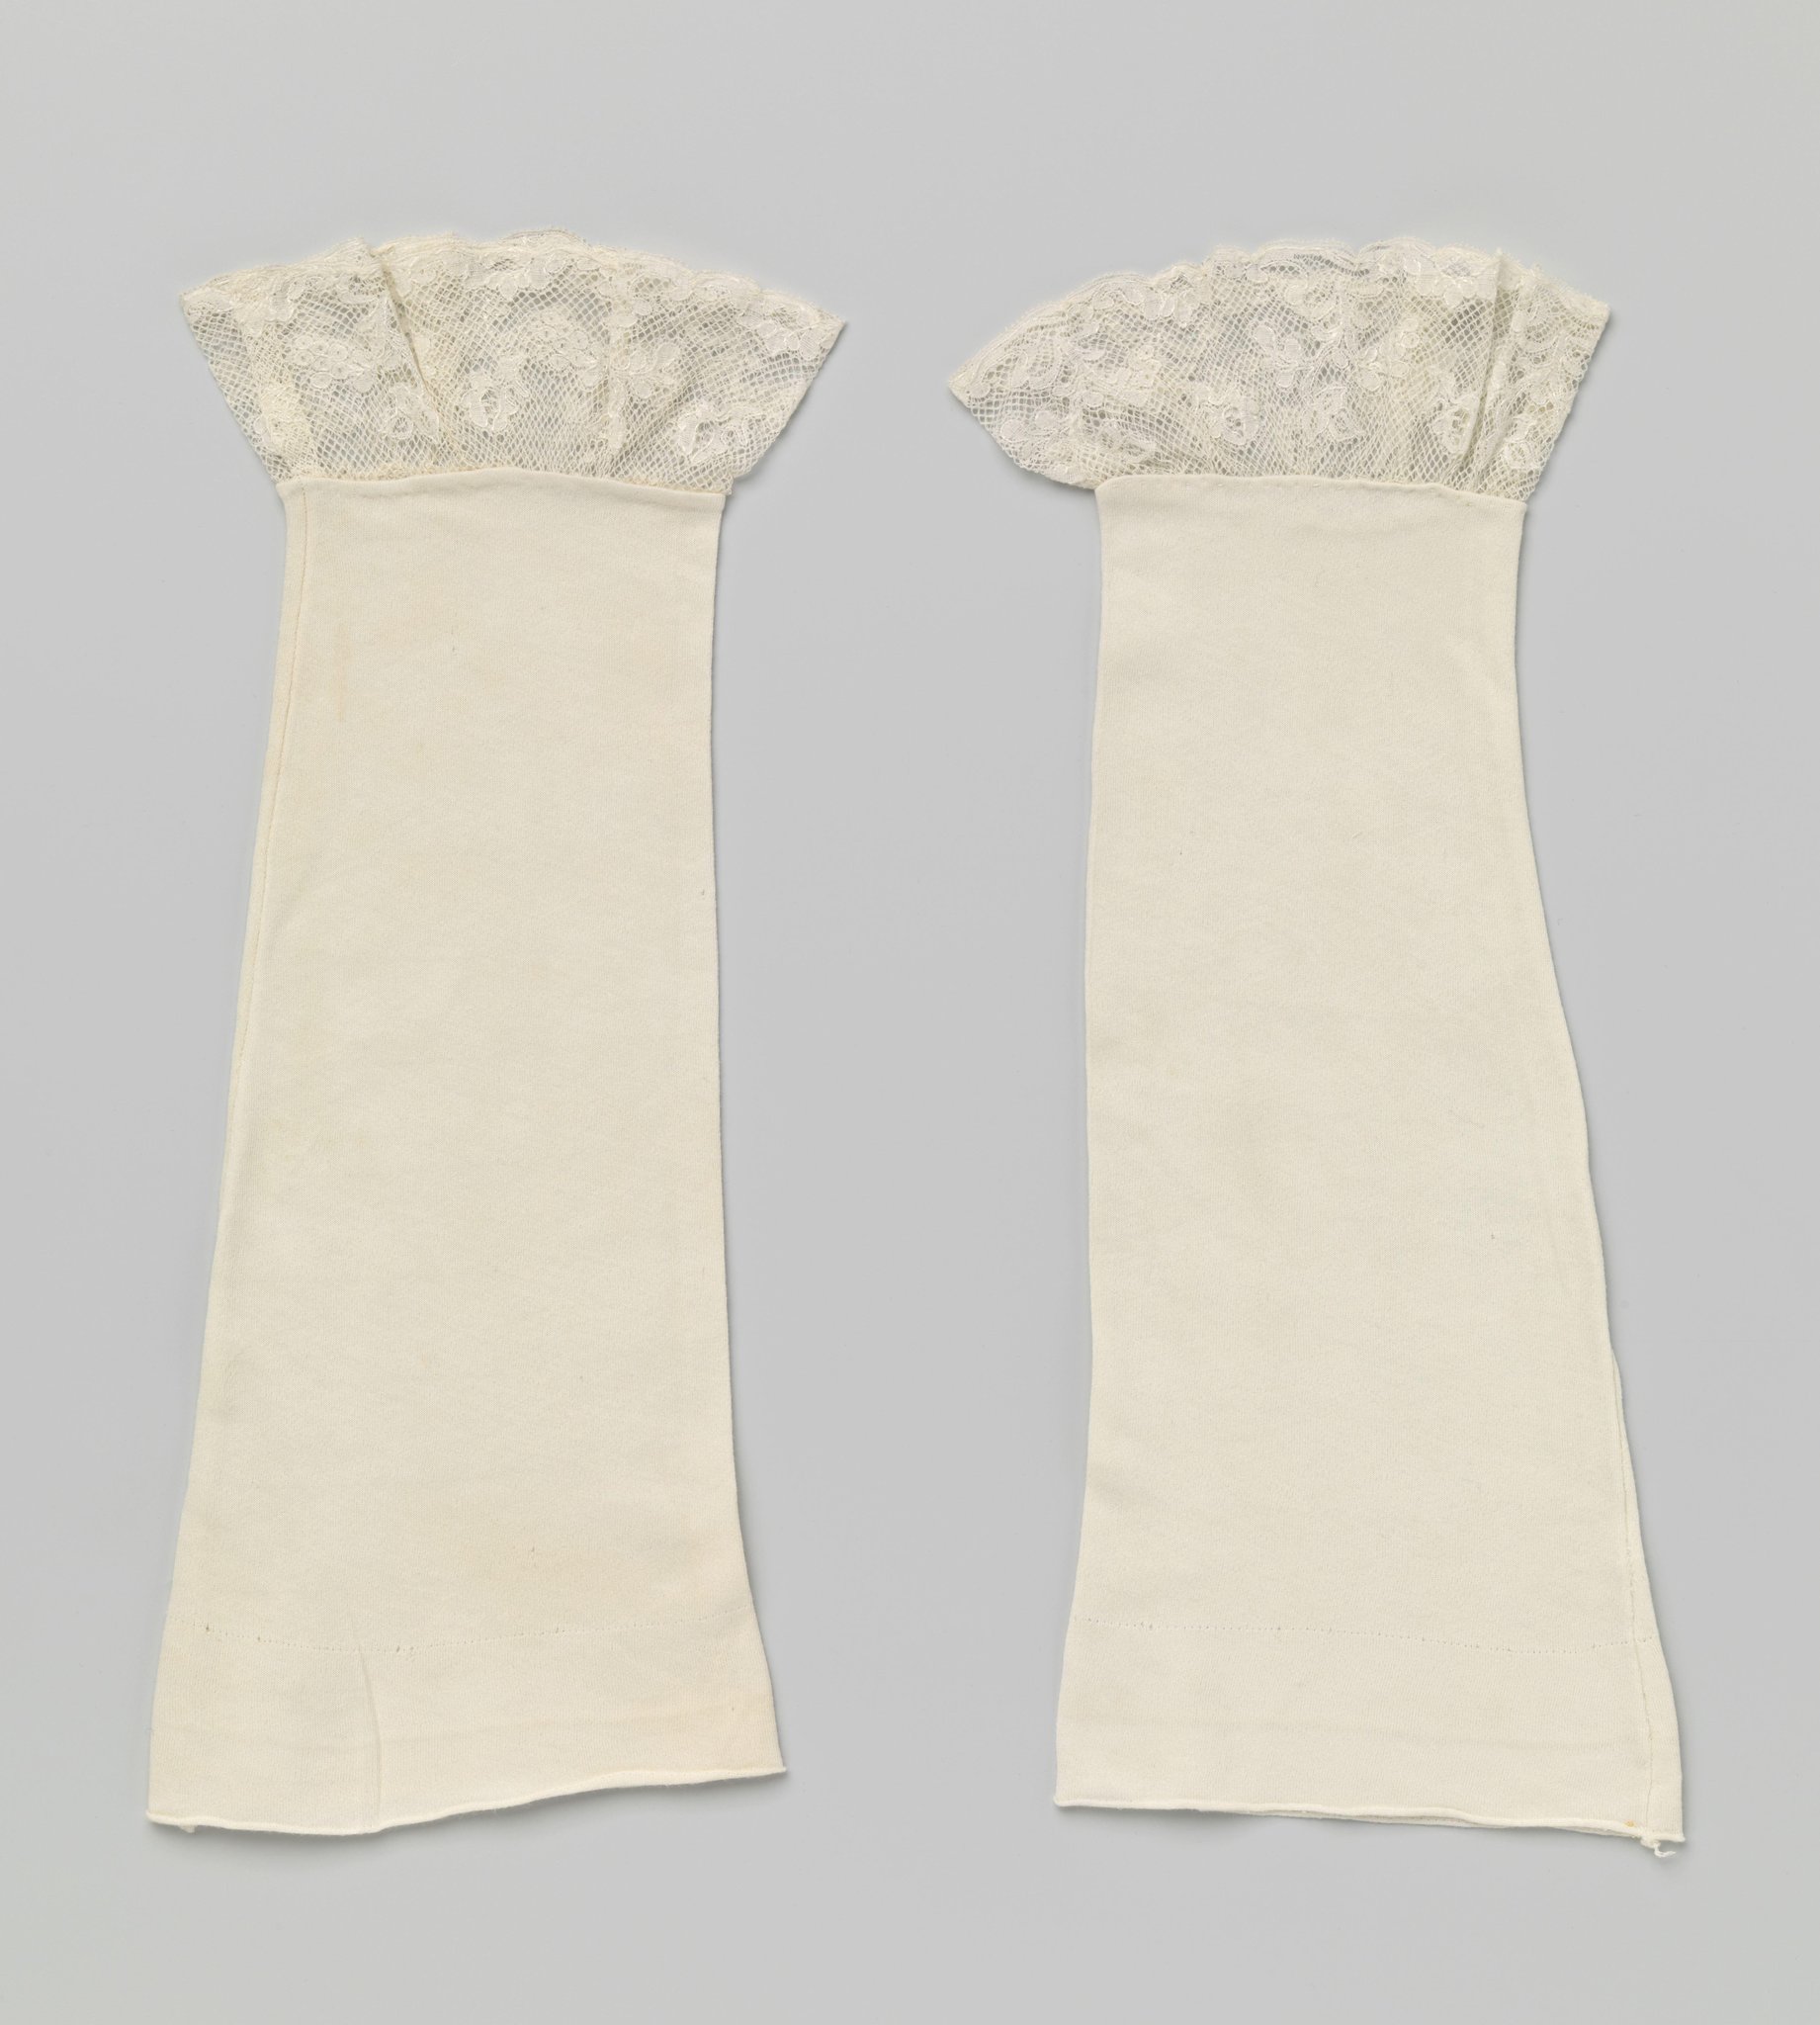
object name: clothing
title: Ondermouw van witte tricot met manchet van machinale kant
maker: Anonymous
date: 1935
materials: cotton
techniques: cockled, lace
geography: western europe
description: Ondermouw van tricot met manchetten van machinale kant. Model als kousenbeen met afhangende gerimpelde kantstrook, imitatie van Mechelse kant. Ondermouw gemerkt 'Thyra 9'